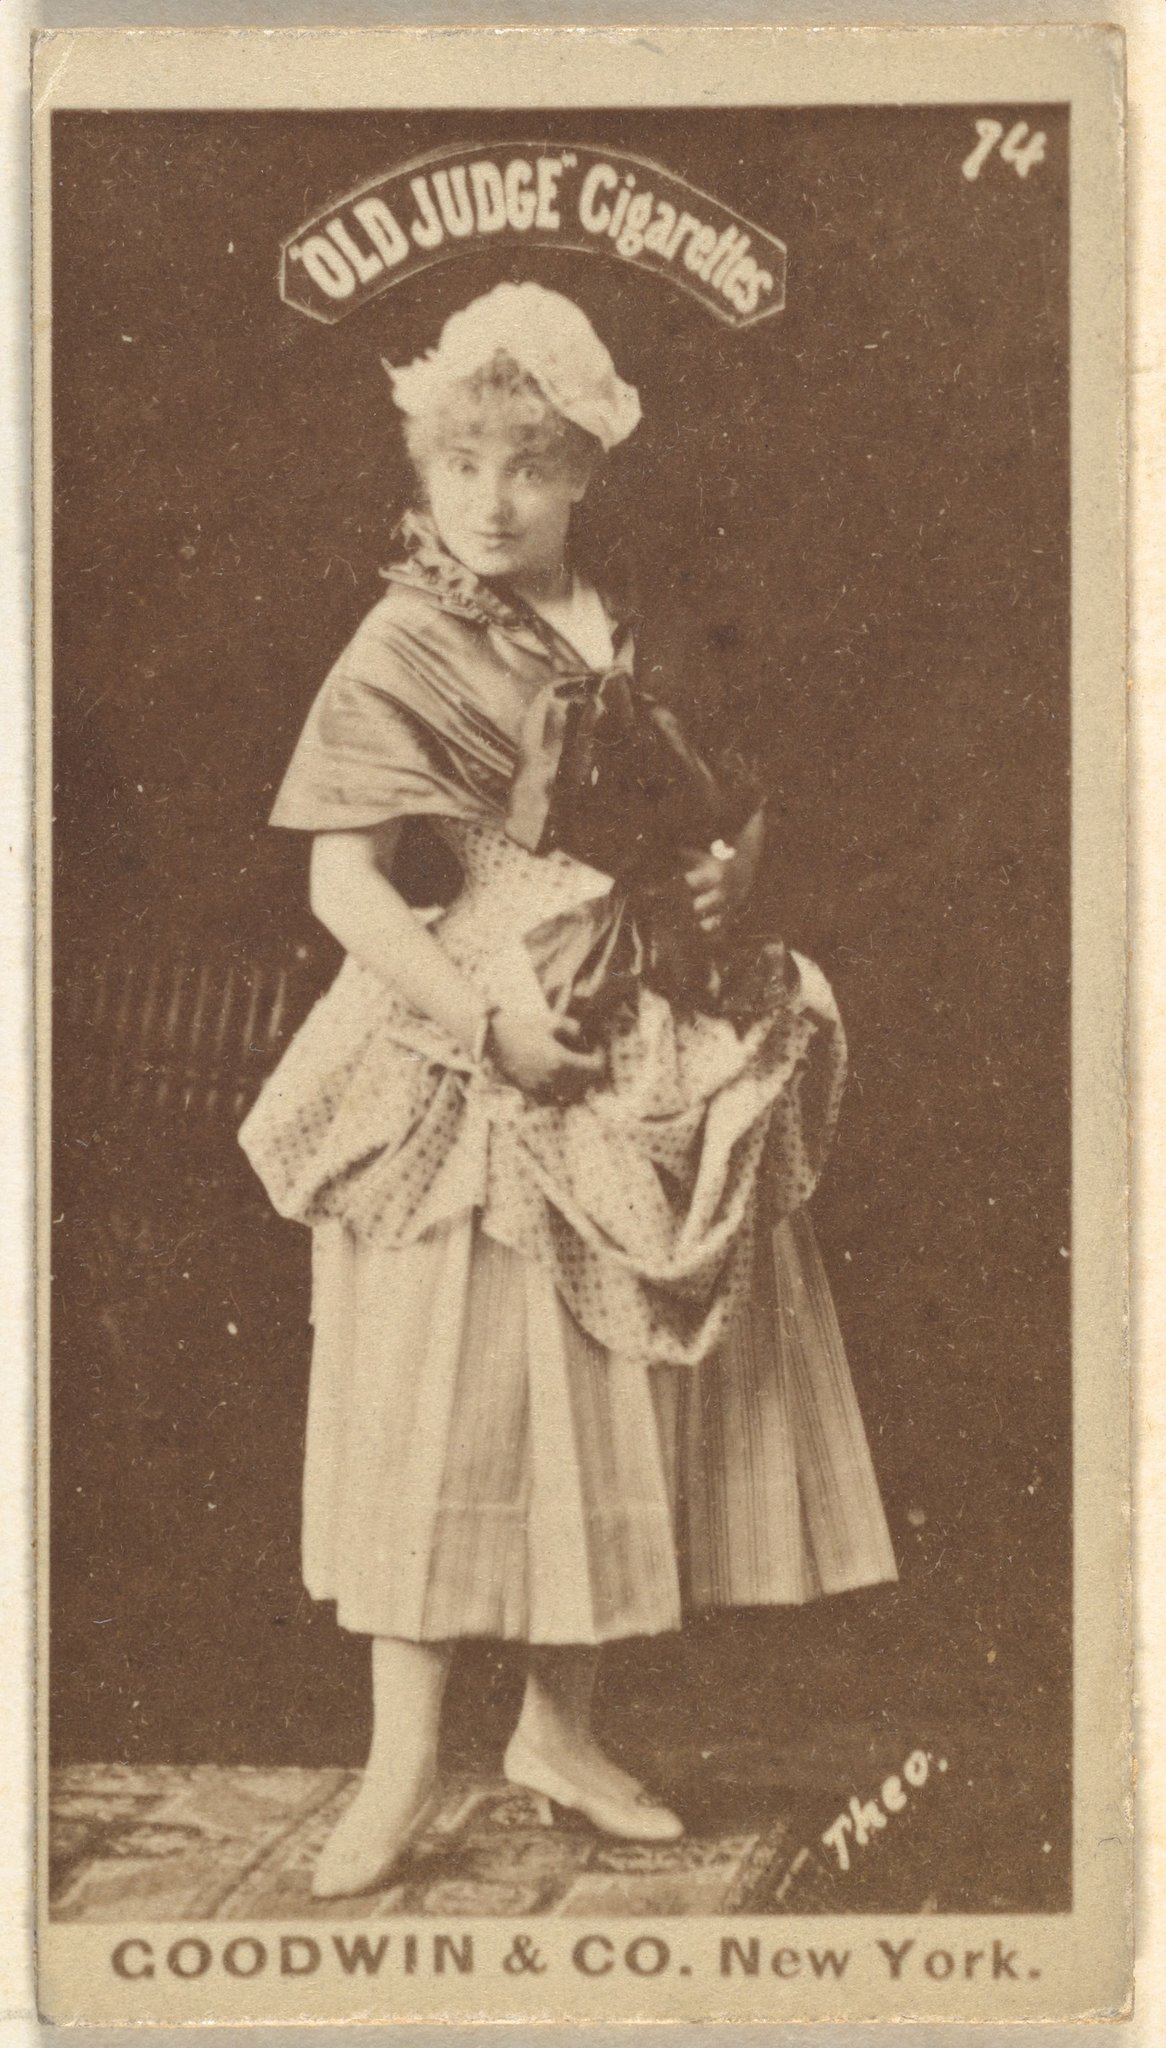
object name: photograph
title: Theo, from the Actors and Actresses series (N171) for Old Judge Cigarettes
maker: goodwin & company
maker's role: publisher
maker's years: 1850-1950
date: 1886-1890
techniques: albumen silver print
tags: portraits,women,actresses